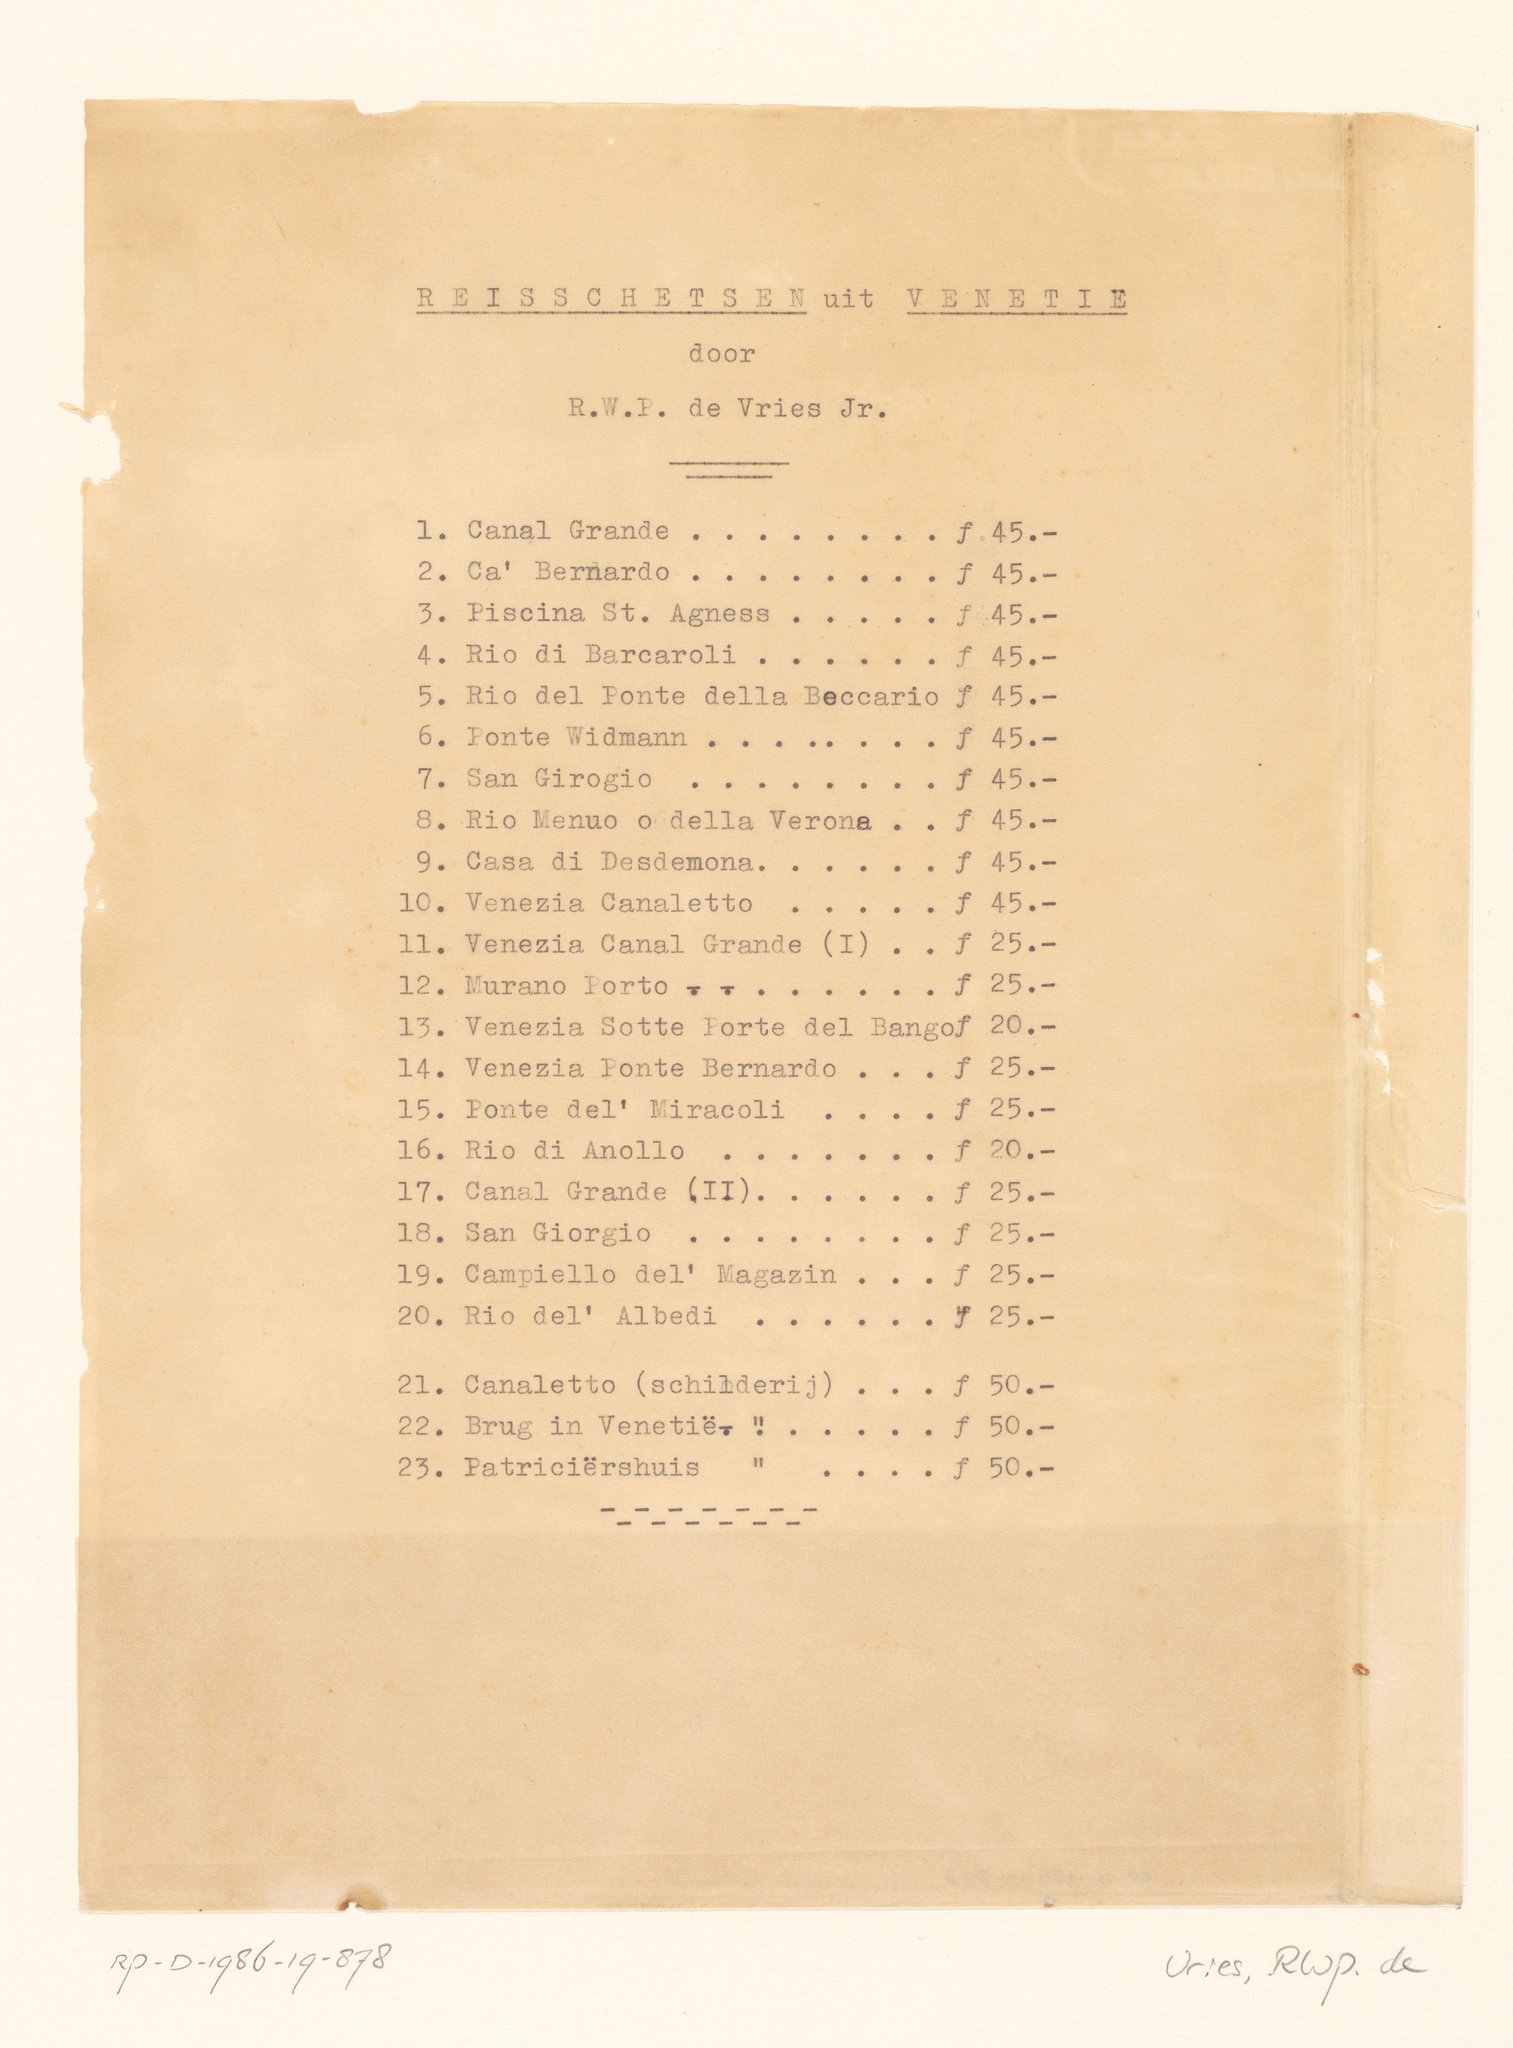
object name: list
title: Prijslijst van reisschetsen uit Venetië gemaakt door R.W.P. de Vries Jr.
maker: reinier willem petrus de vries (1874-1953)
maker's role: draughtsman, print maker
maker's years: 1874-1953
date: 1884-1952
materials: paper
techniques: typewriting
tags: venice